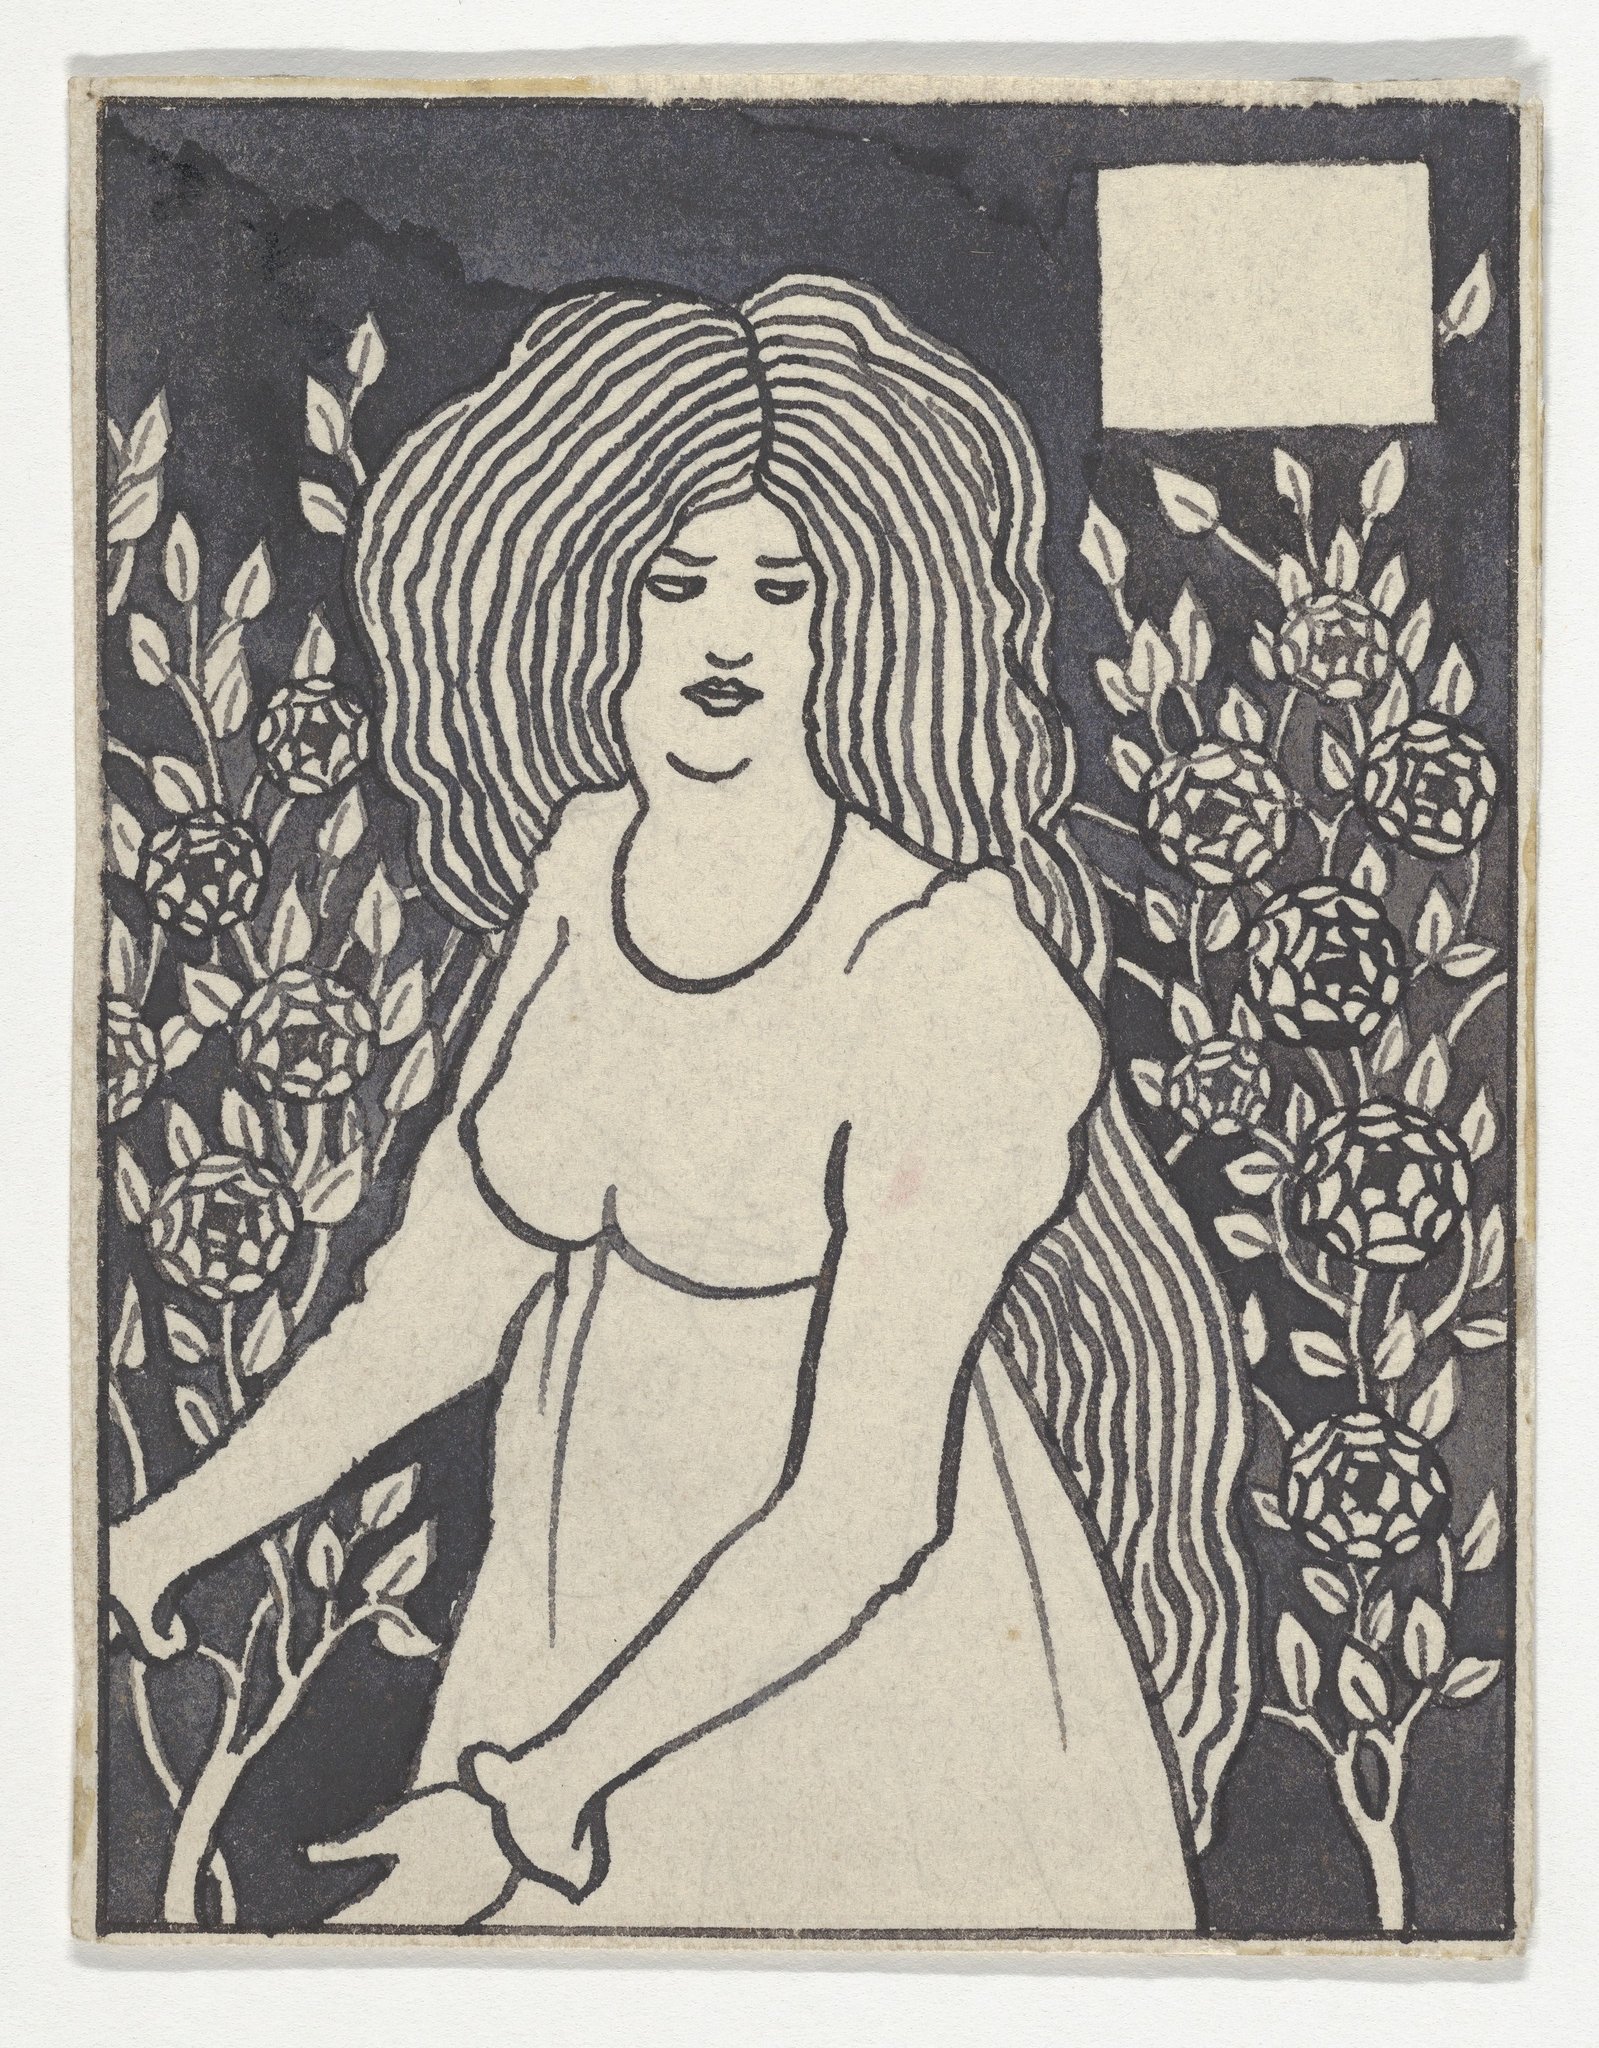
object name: drawing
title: Long-haired Woman in Front of Tall Rosebushes (Chapter Heading, "Le Morte d'Arthur," J. M. Dent, 1893–4, Part IX, book xiii, chapter viii, p. 700, and Part XII, book xxi, chapter viii, p. 972)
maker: aubrey vincent beardsley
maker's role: artist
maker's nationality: british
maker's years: 1872-1898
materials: graphite, ink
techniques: brush, pen, wash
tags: hair,women,roses